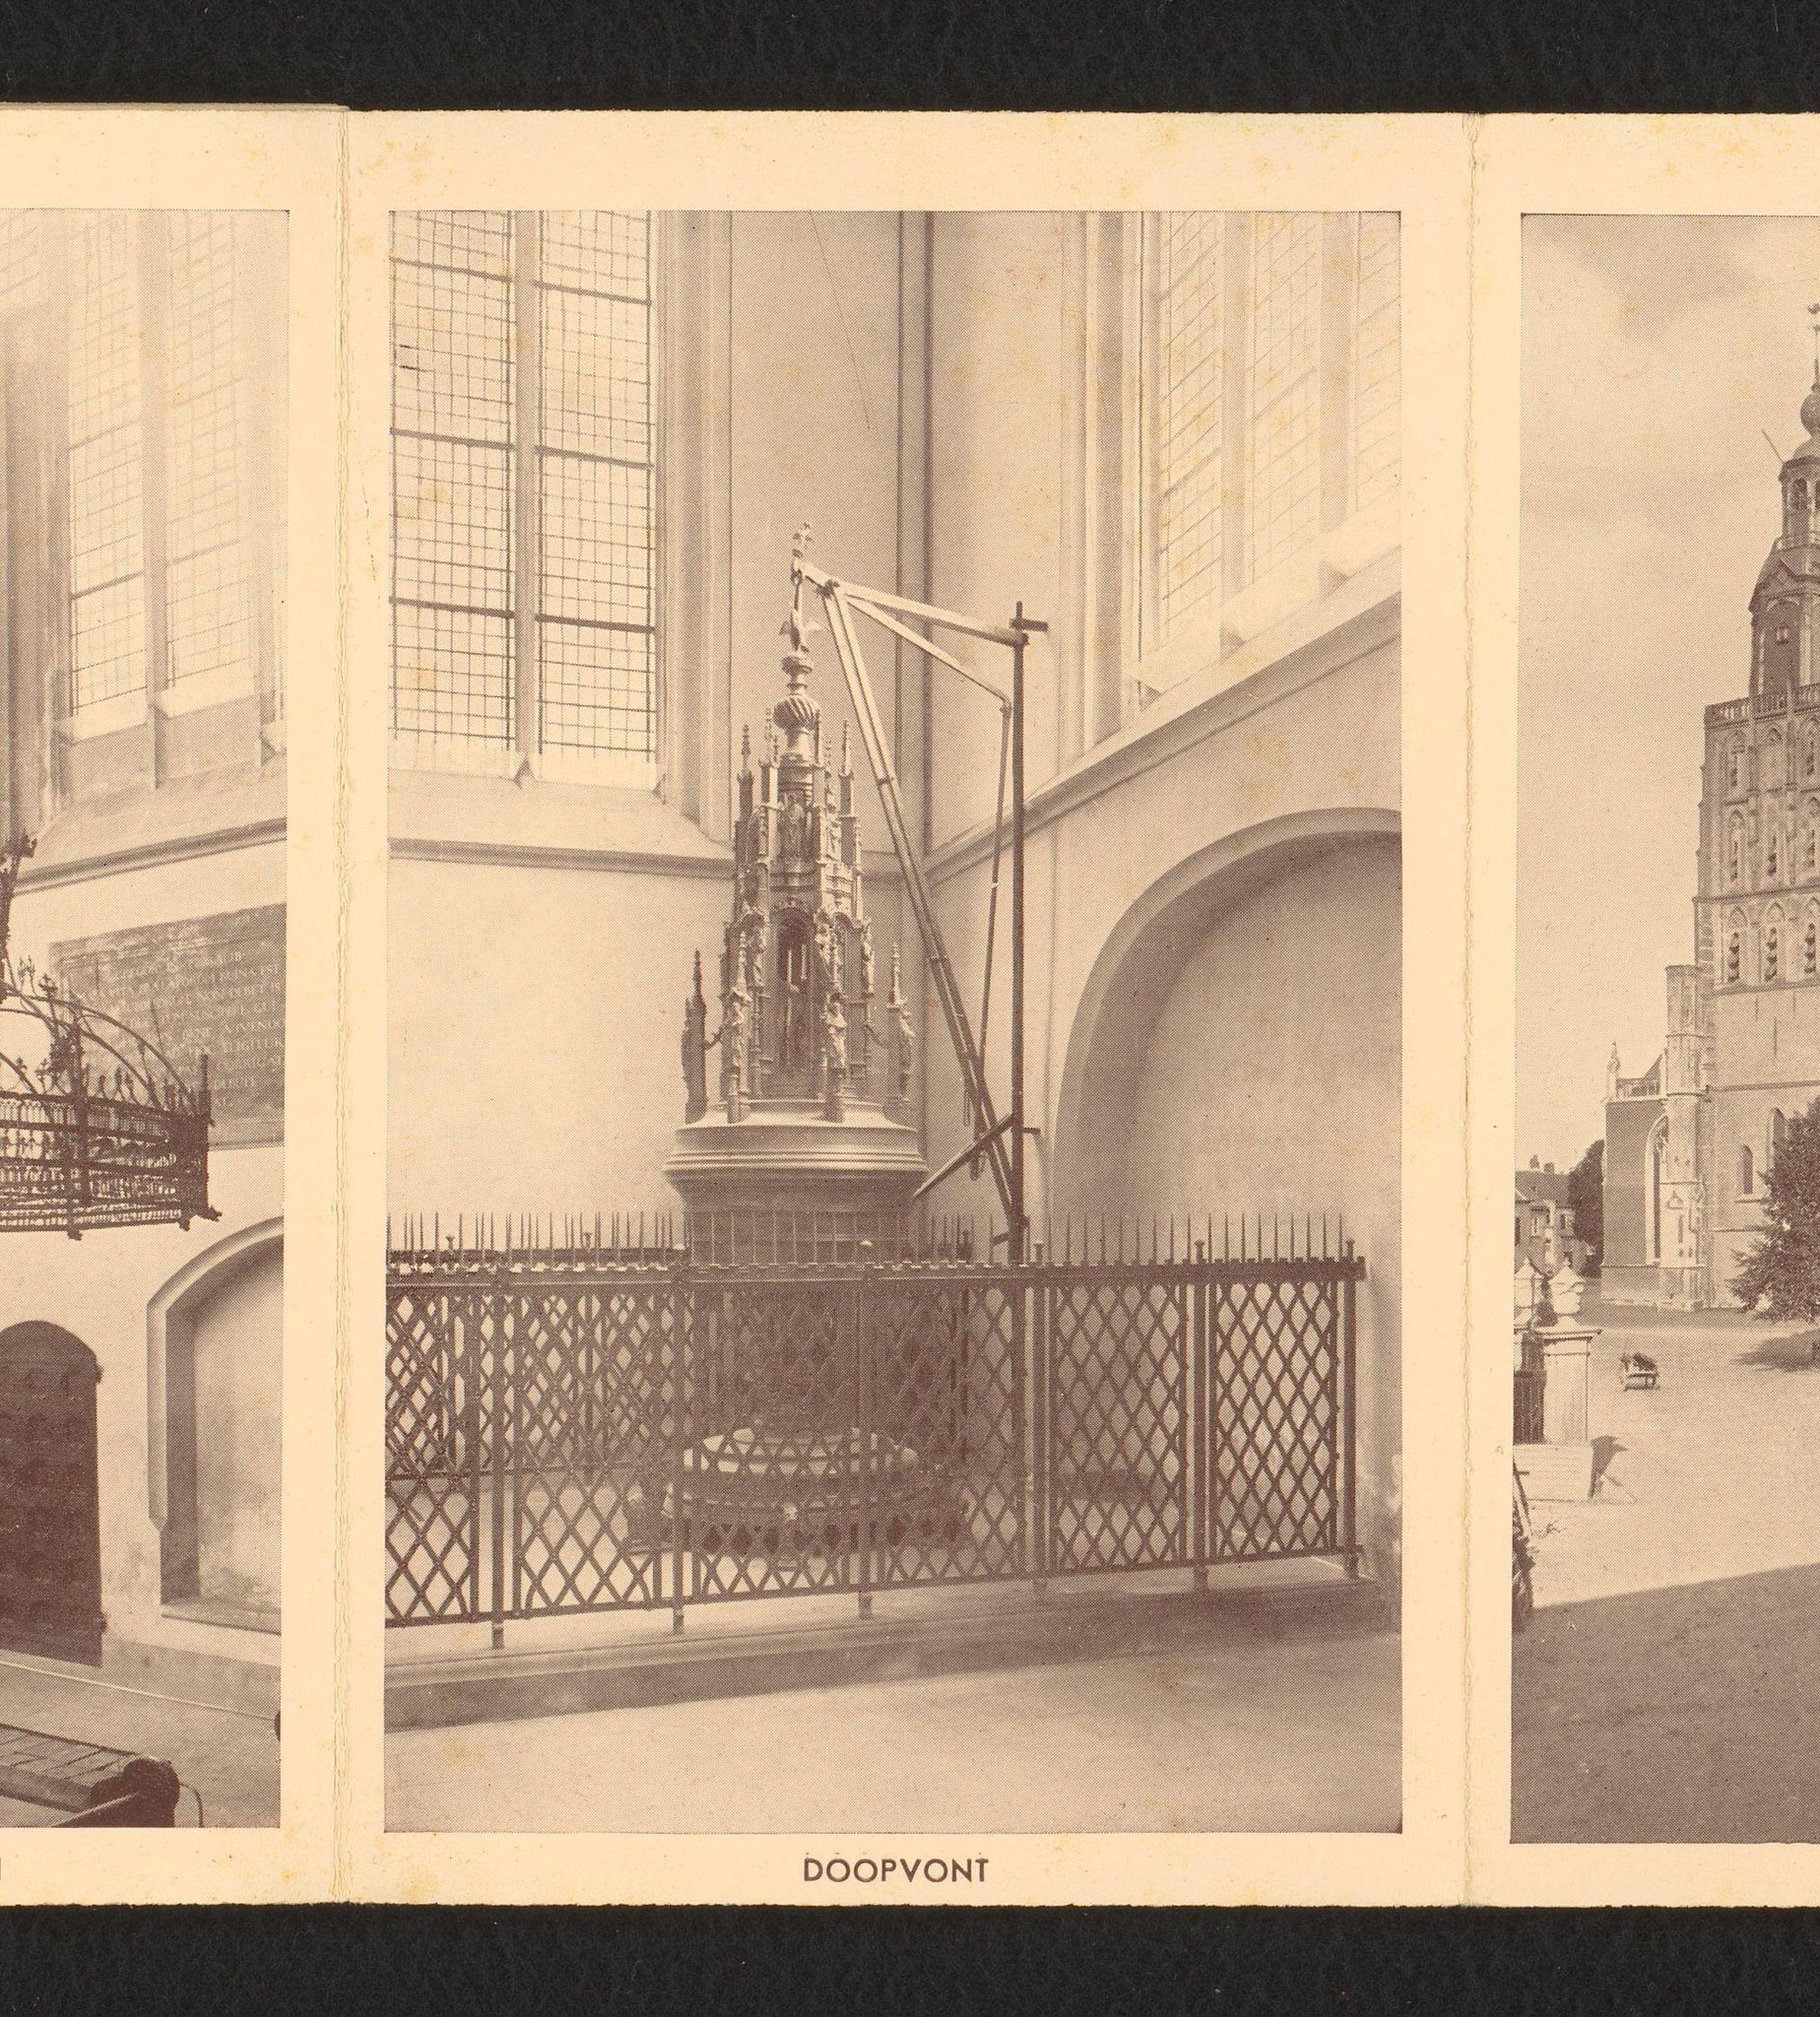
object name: photomechanical print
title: Doopvont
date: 1925-1940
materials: cardboard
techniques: autotype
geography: zutphen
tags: interior of church, baptismal font